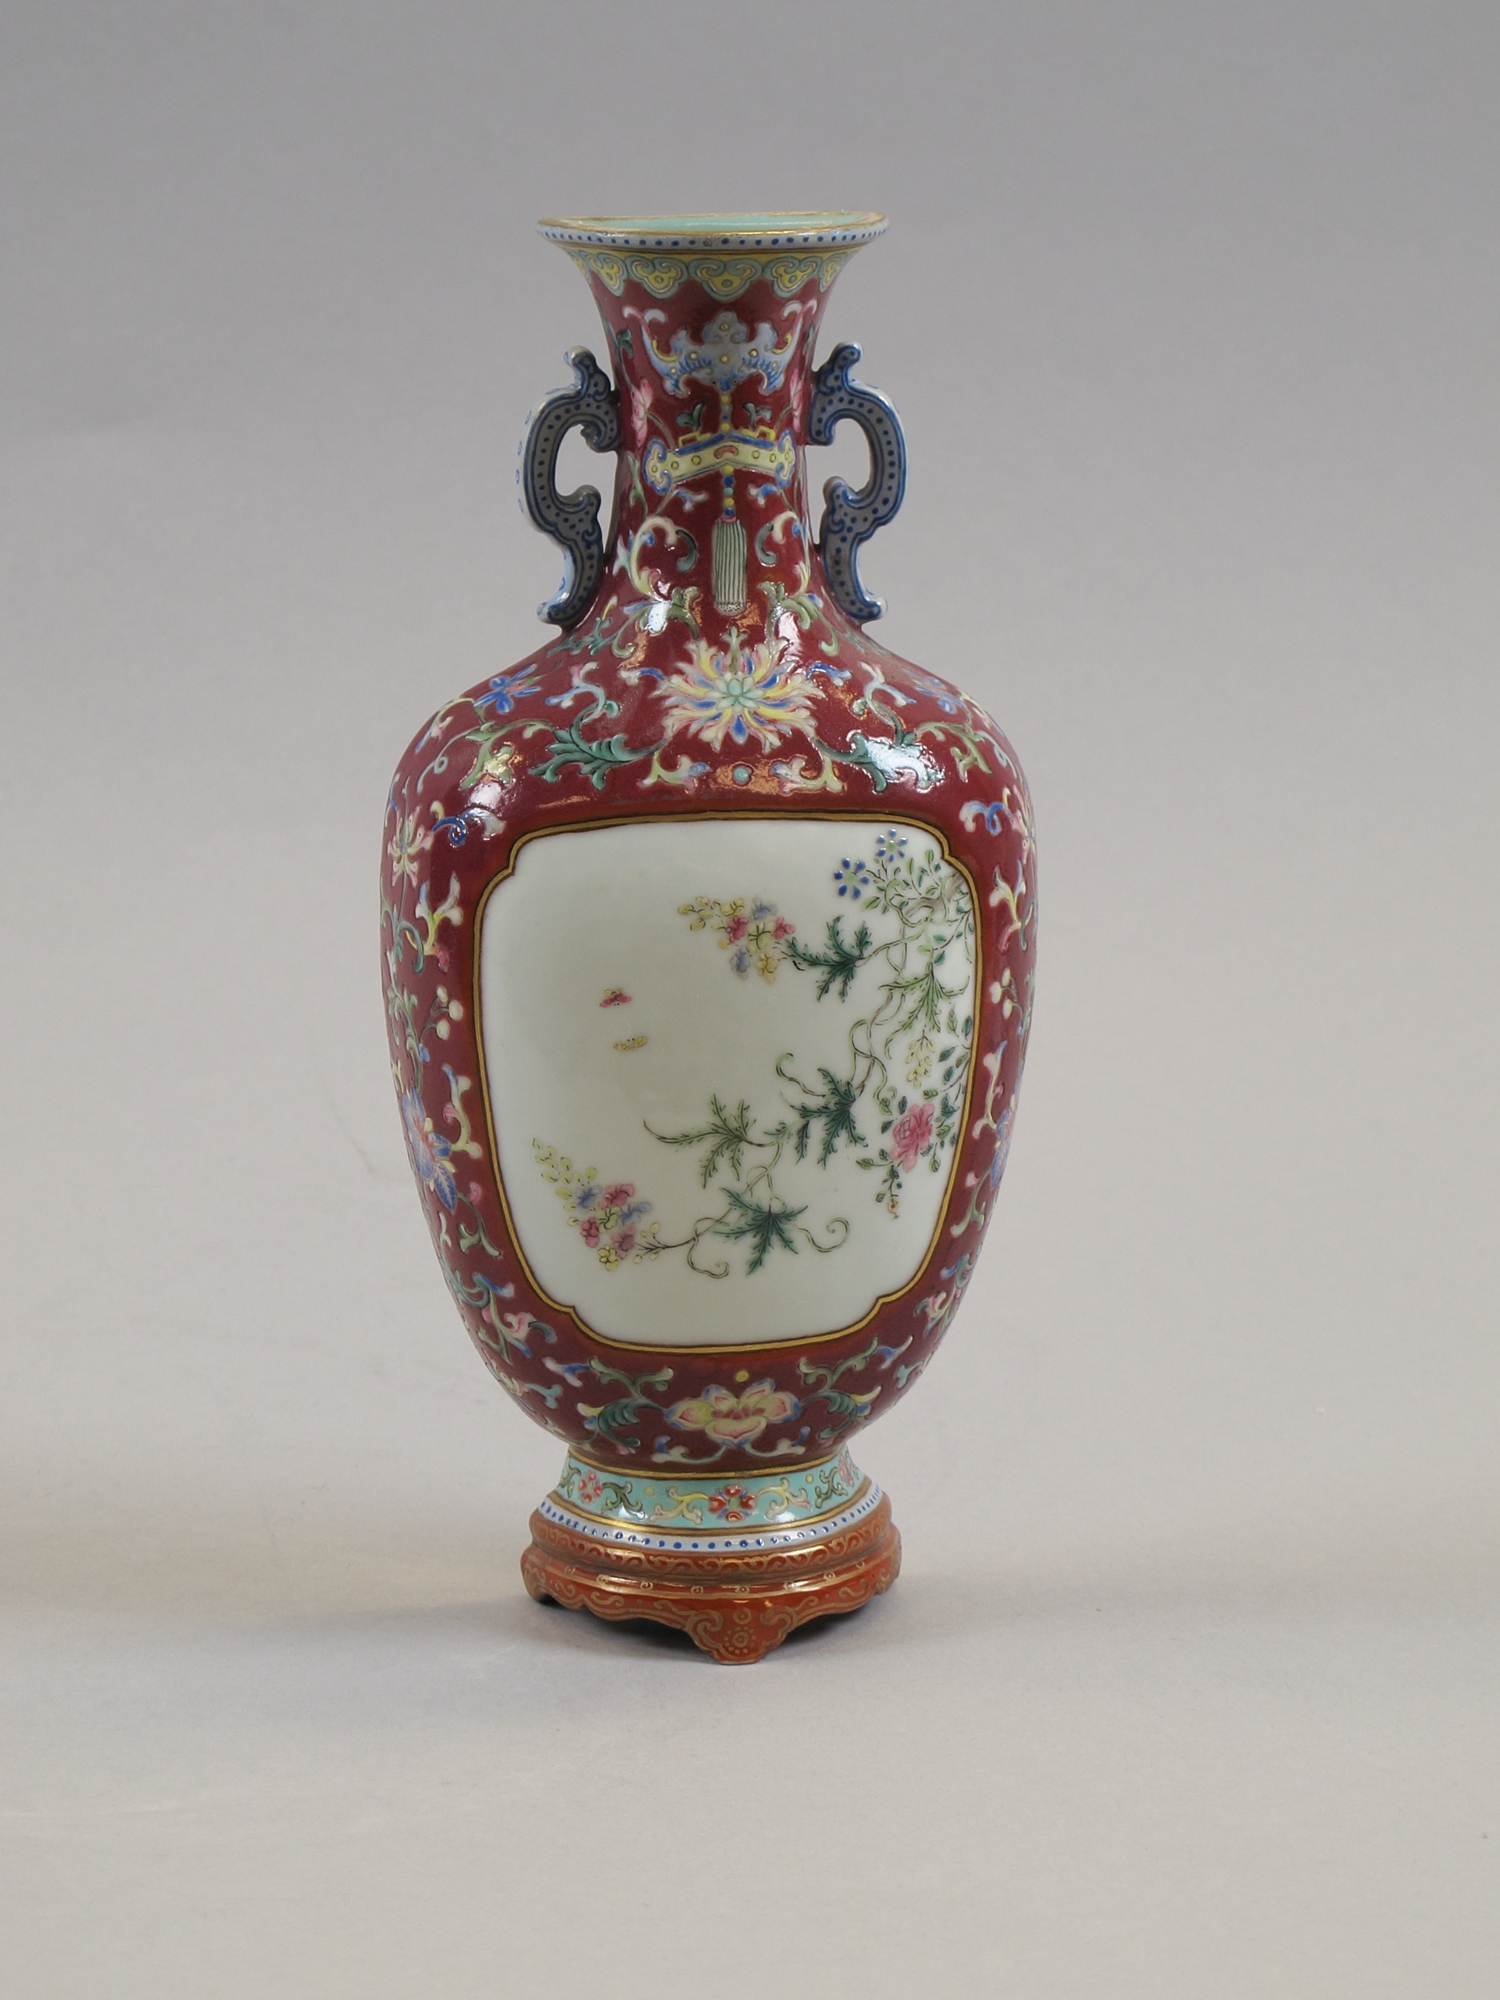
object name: wall vase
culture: chinese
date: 1701-1900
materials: enamel, porcelain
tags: flowers,plants